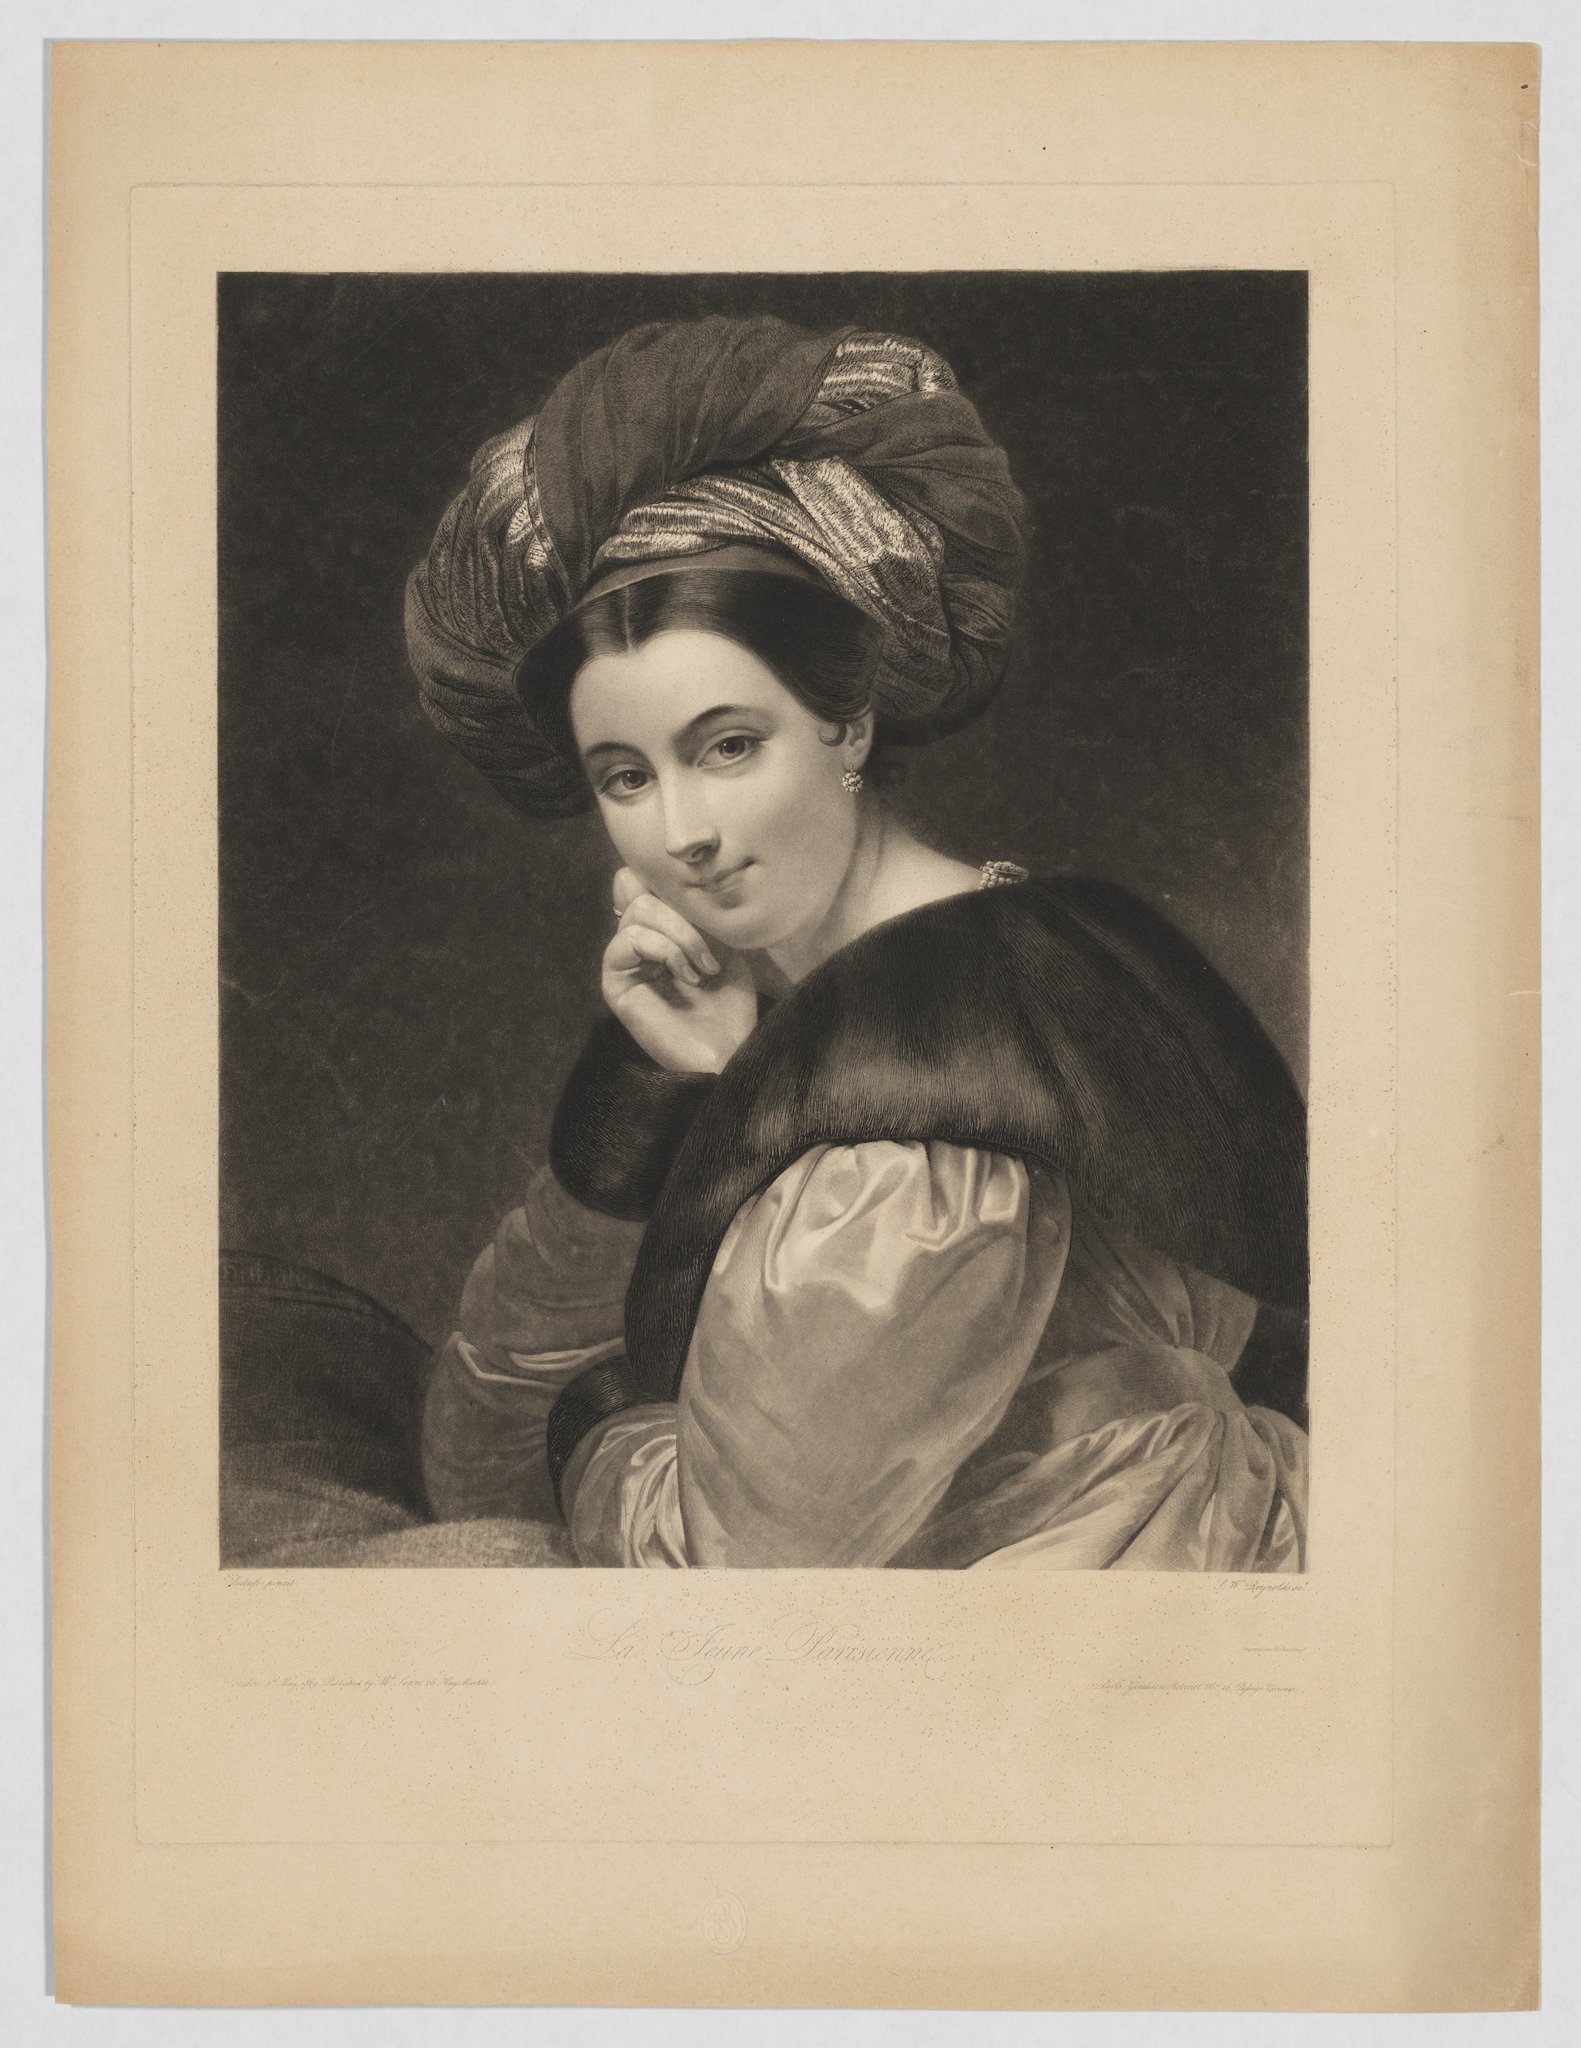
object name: print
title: La Jeune Parisienne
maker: samuel william reynolds, the elder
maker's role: artist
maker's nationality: british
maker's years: 1773-1835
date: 1829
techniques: etching, mezzotint